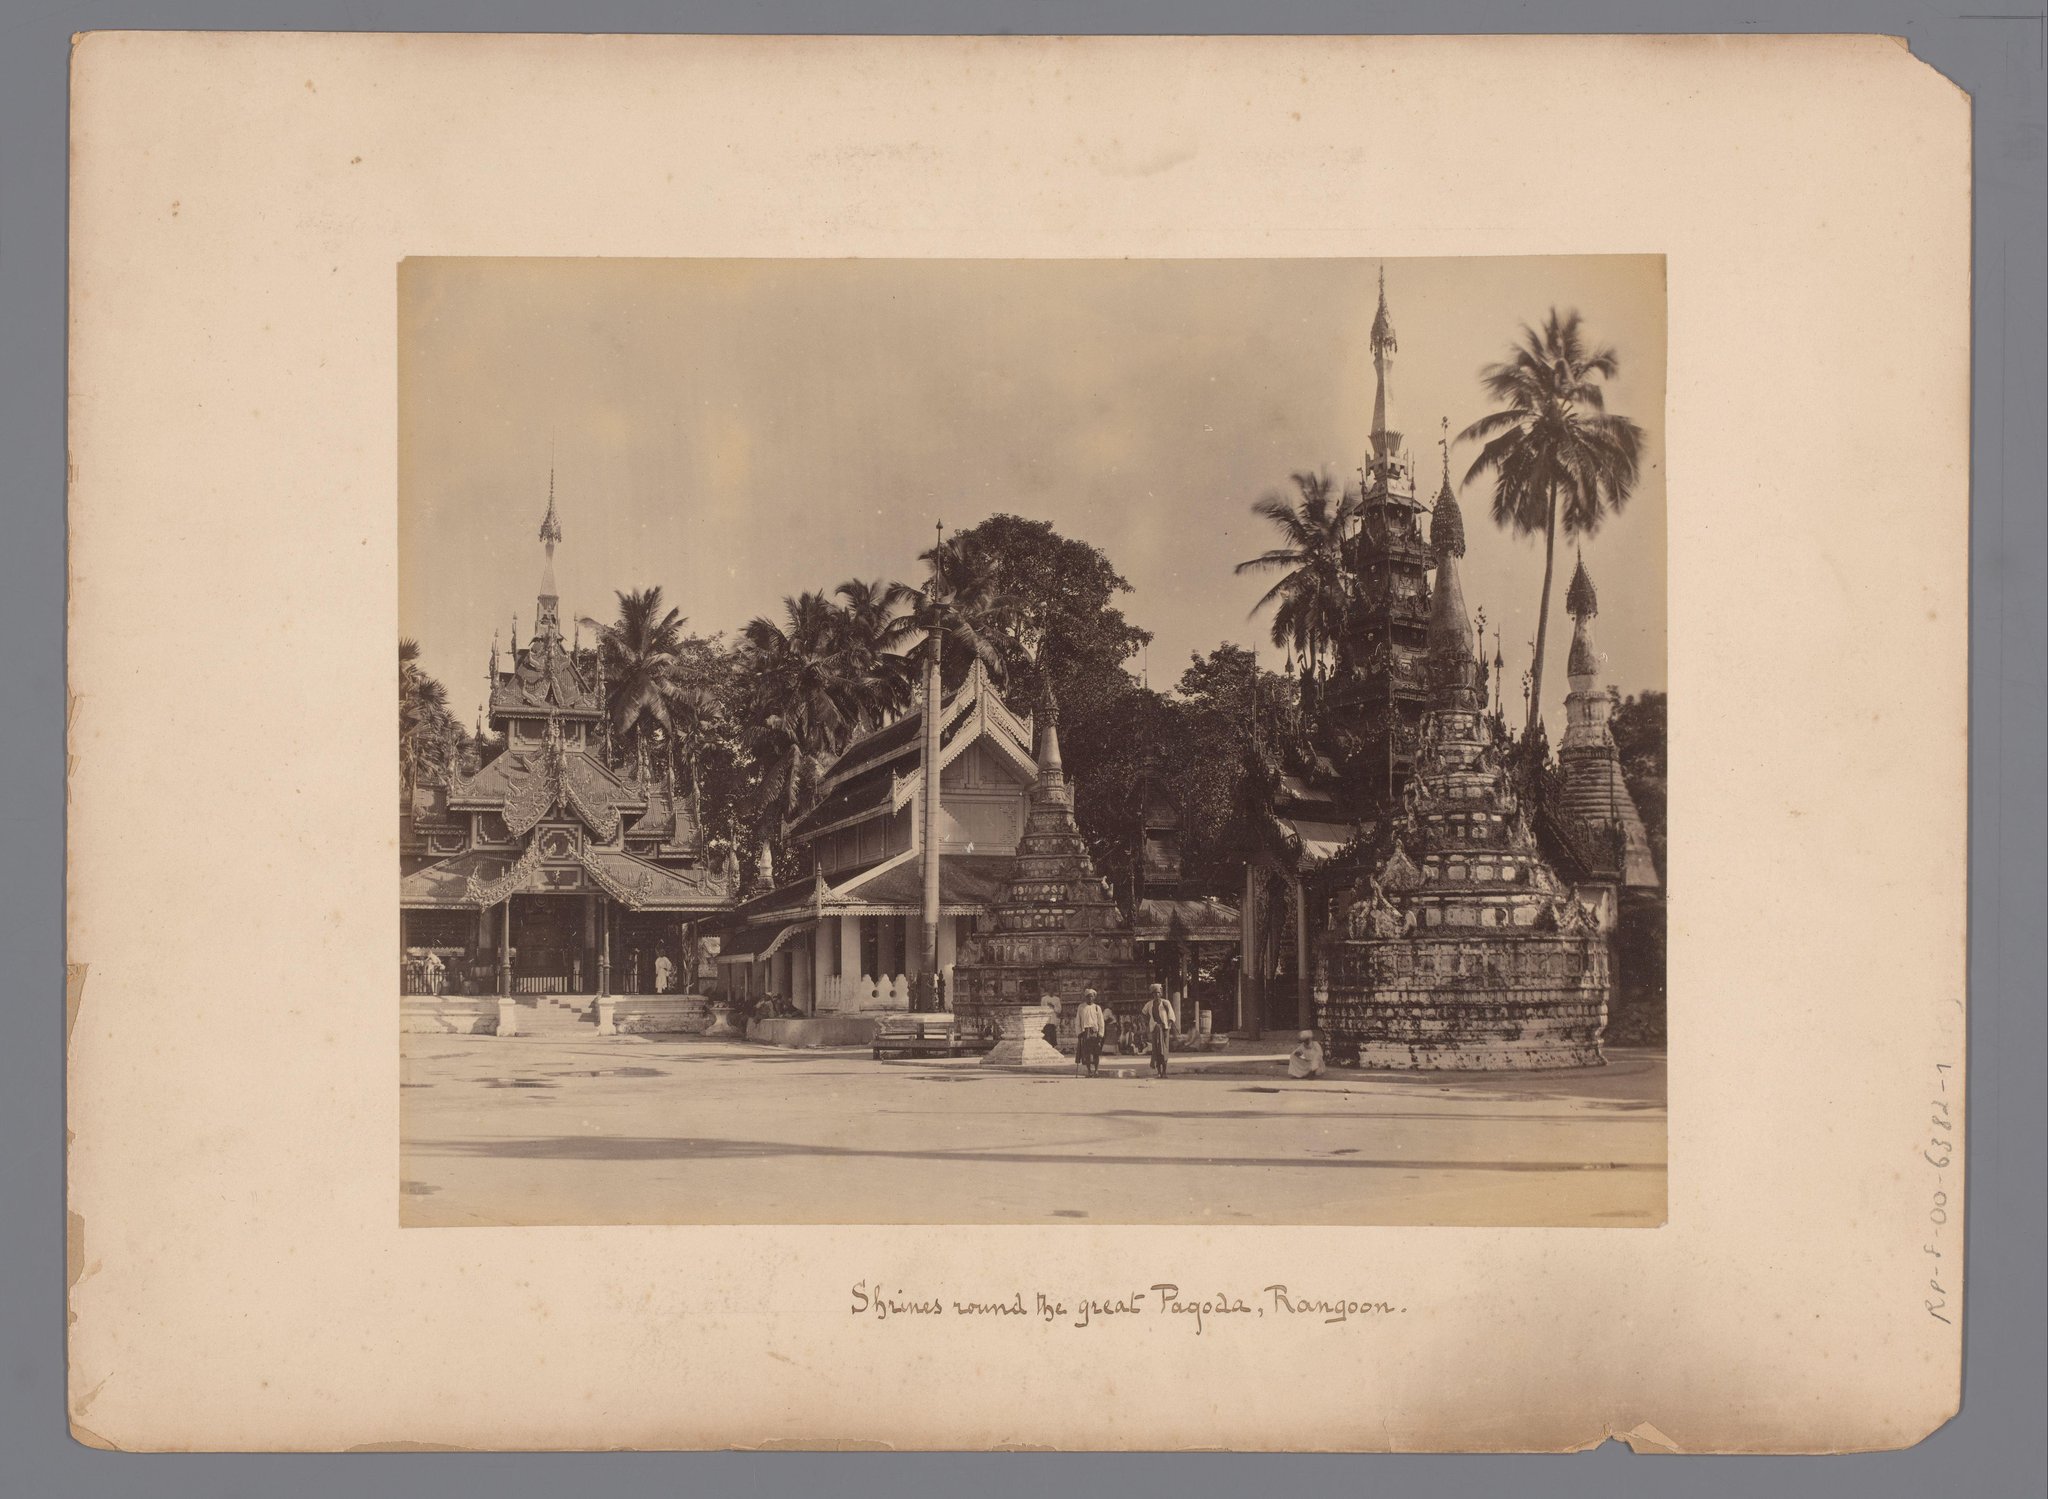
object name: photograph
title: Shrine around the Shwedagon Pagoda, Yangon, Myanmar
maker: Anonymous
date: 1880-1900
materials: cardboard, photographic support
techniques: albumen print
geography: yangon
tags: myanmar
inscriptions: caption: ‘Shrines round the great Pagoda, Rangoon’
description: Pagode met grafkamers en palmbomen, genomen vanaf een open plaats. Het land heet sinds 1989 officieel Unie van Myanmar, daarvoor heette het Birma. De hoofdstad is sinds 7 november 2005 officieel het centraal gelegen Naypyidaw (bij Pyinmana), zij het dat de verhuizing op die datum pas begon. De voormalige hoofdstad is Rangoon (Yangon), de grootste stad van het land.